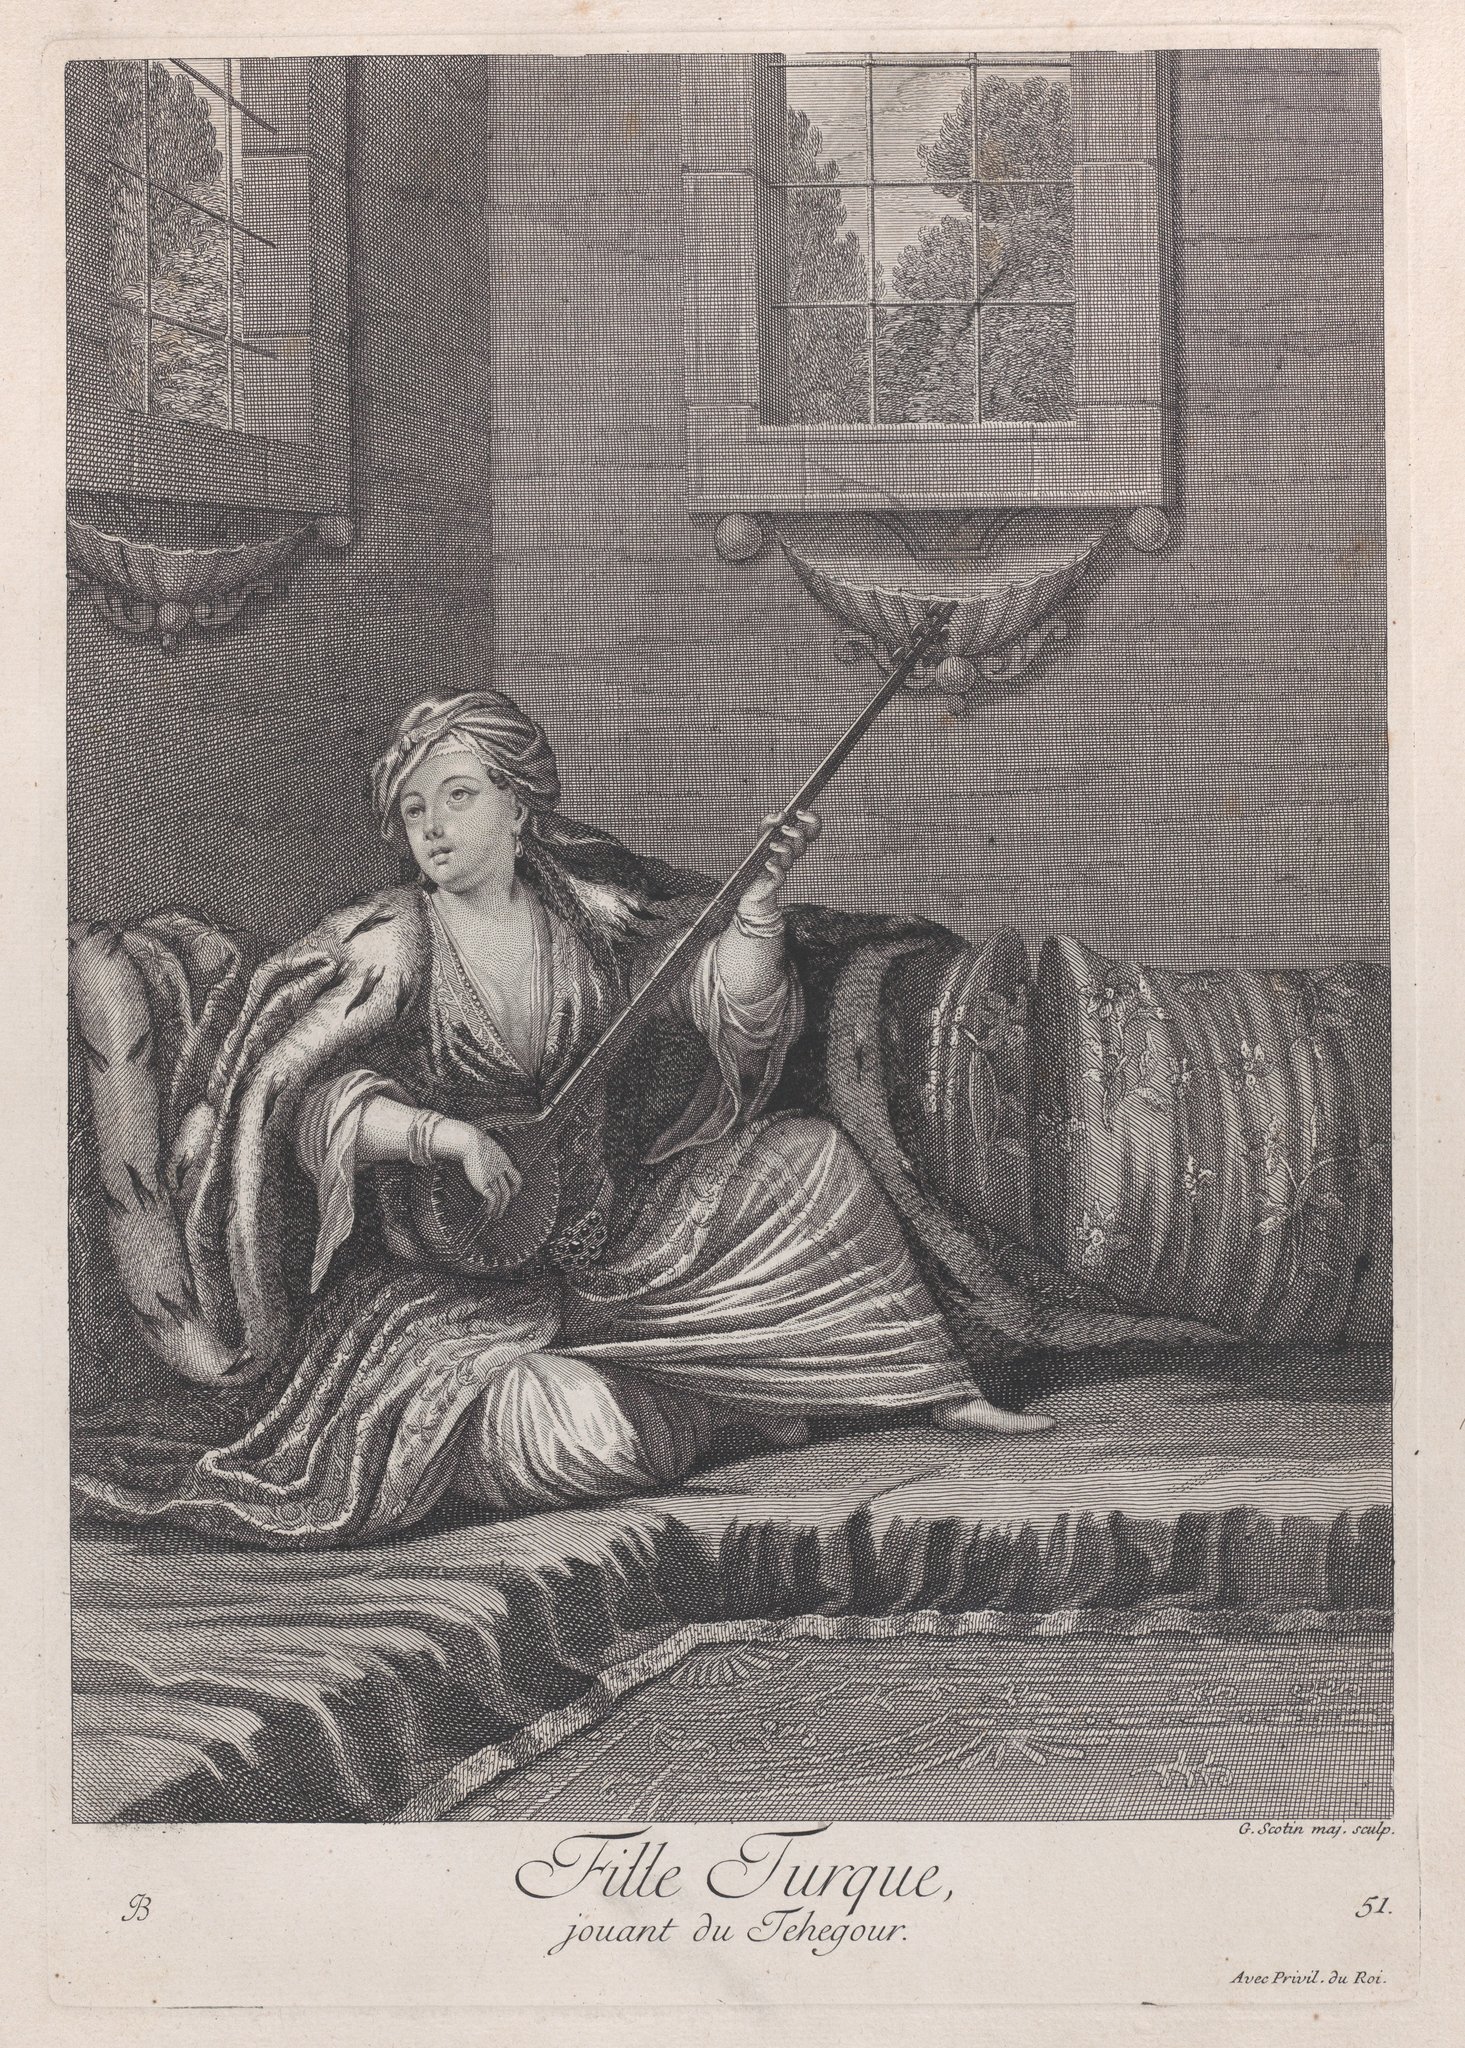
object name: print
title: Fille Turque, jouant du Tehegour, plate 51 from "Recueil de cent estampes représentent differentes nations du Levant"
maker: jean baptiste vanmour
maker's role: artist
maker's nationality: french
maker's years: 1671-1737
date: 1714-1715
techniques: engraving, etching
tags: musical instruments,women,musicians